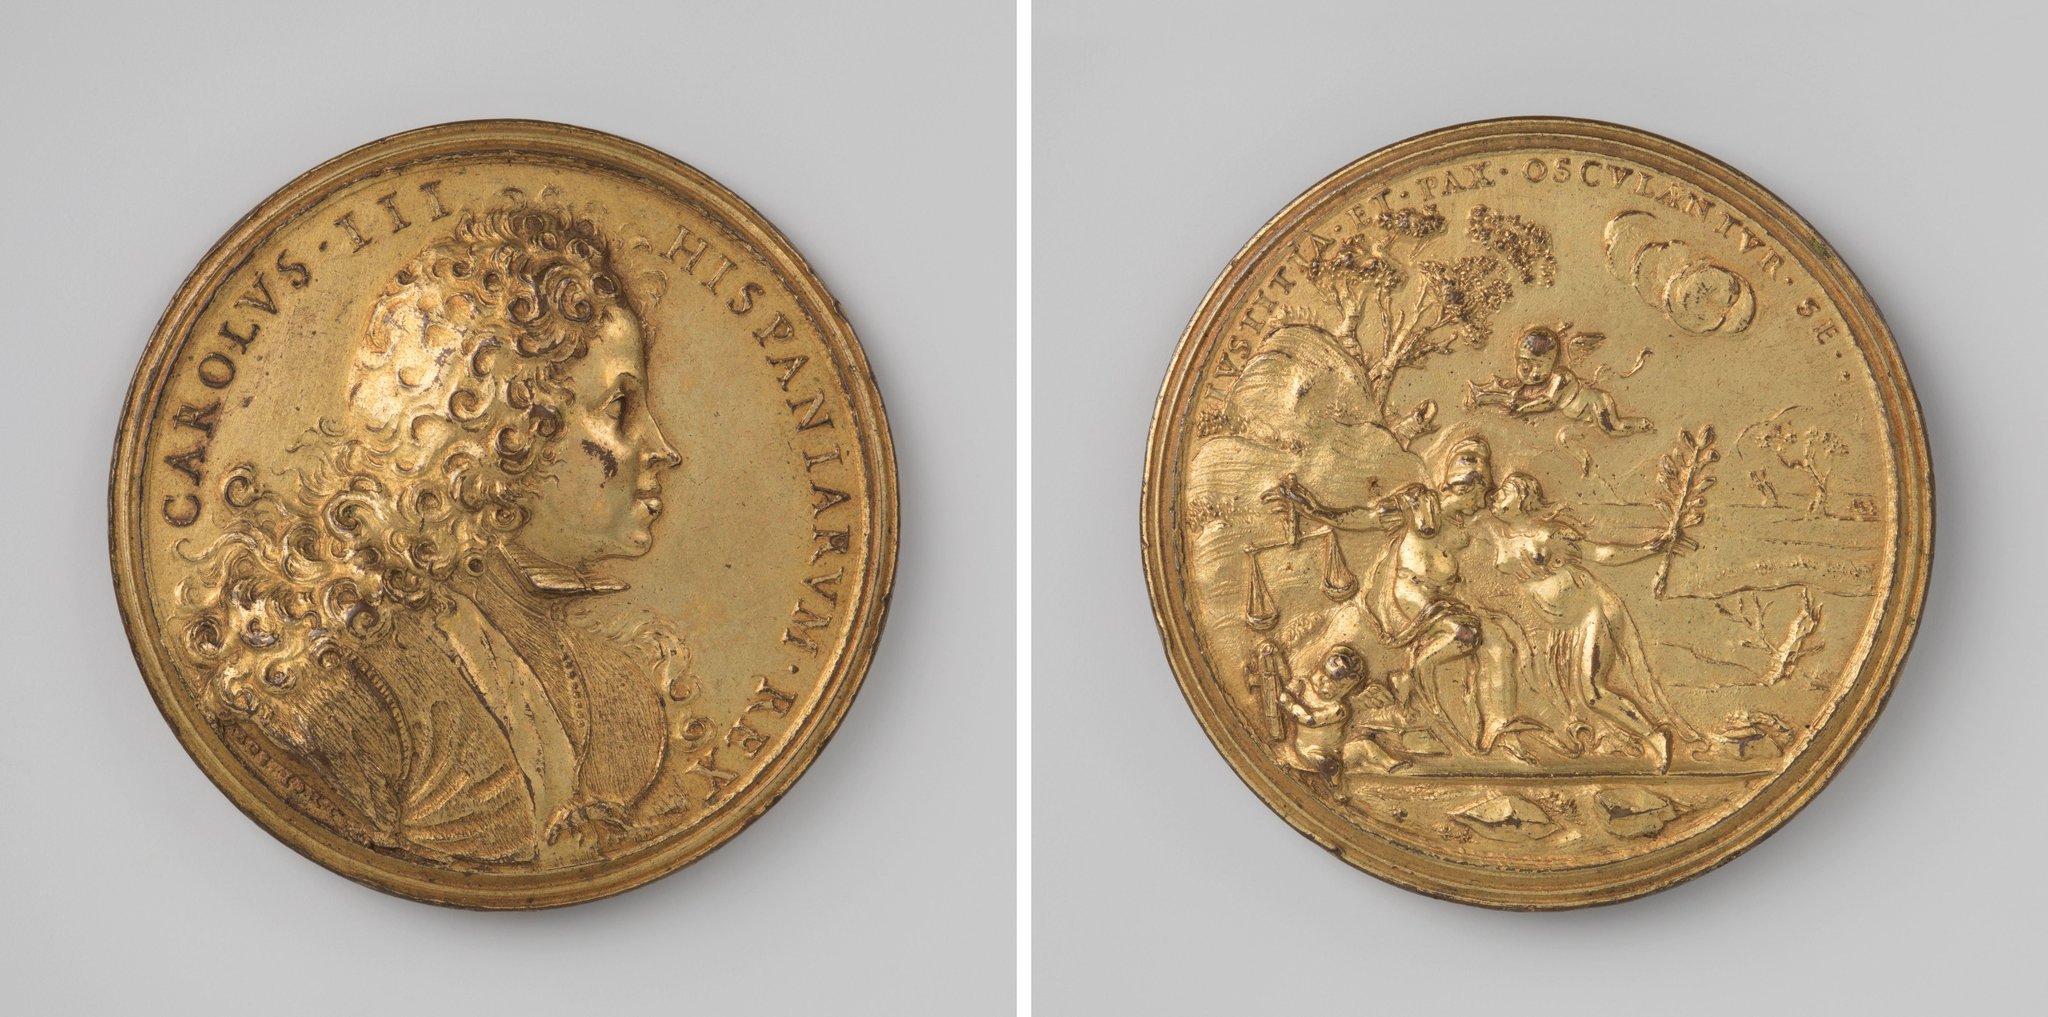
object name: history medal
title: Karel III tot koning van Spanje uitgeroepen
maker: Anonymous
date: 1703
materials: bronze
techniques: gilding, striking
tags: vienna, charles vi (holy roman emperor), spain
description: Bronzen penning. Voorzijde: borststuk man binnen omschrift. Keerzijde: Gerechtigheid met weegschaal en Vrede met olijftak kussen elkaar terwijl engeltje kroon boven hun hoofden houdt binnen omschrift